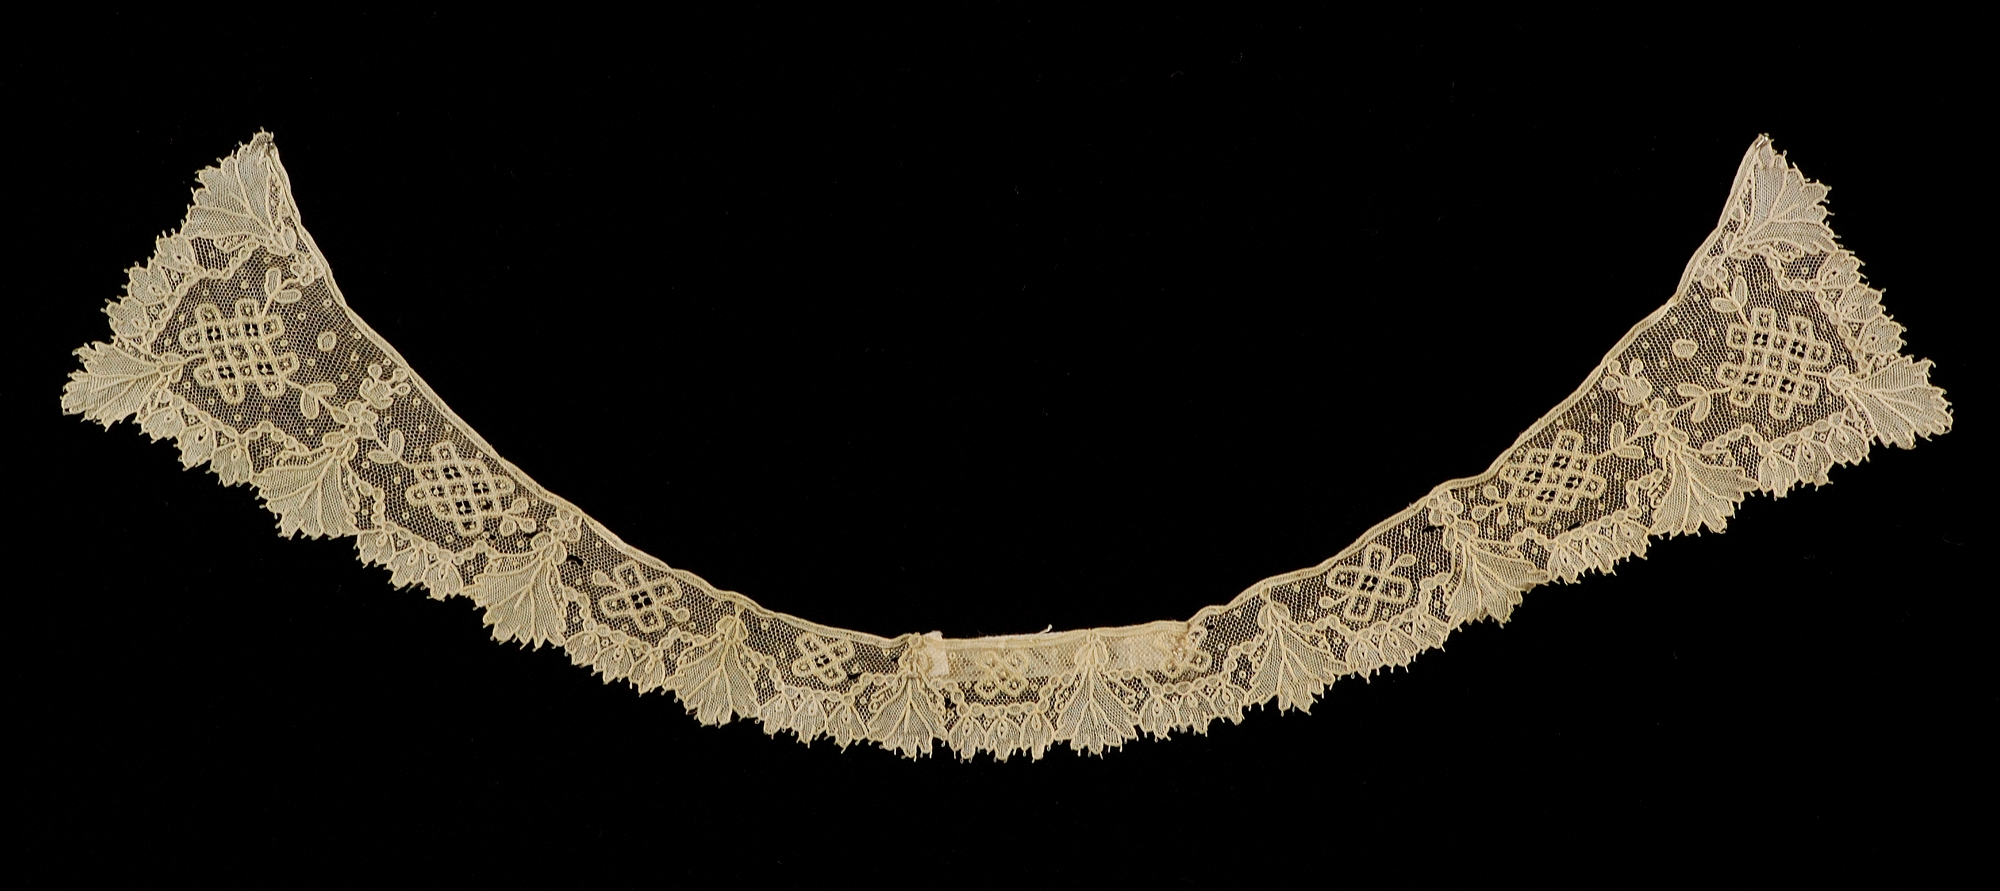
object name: collar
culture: belgian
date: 1860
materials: linen